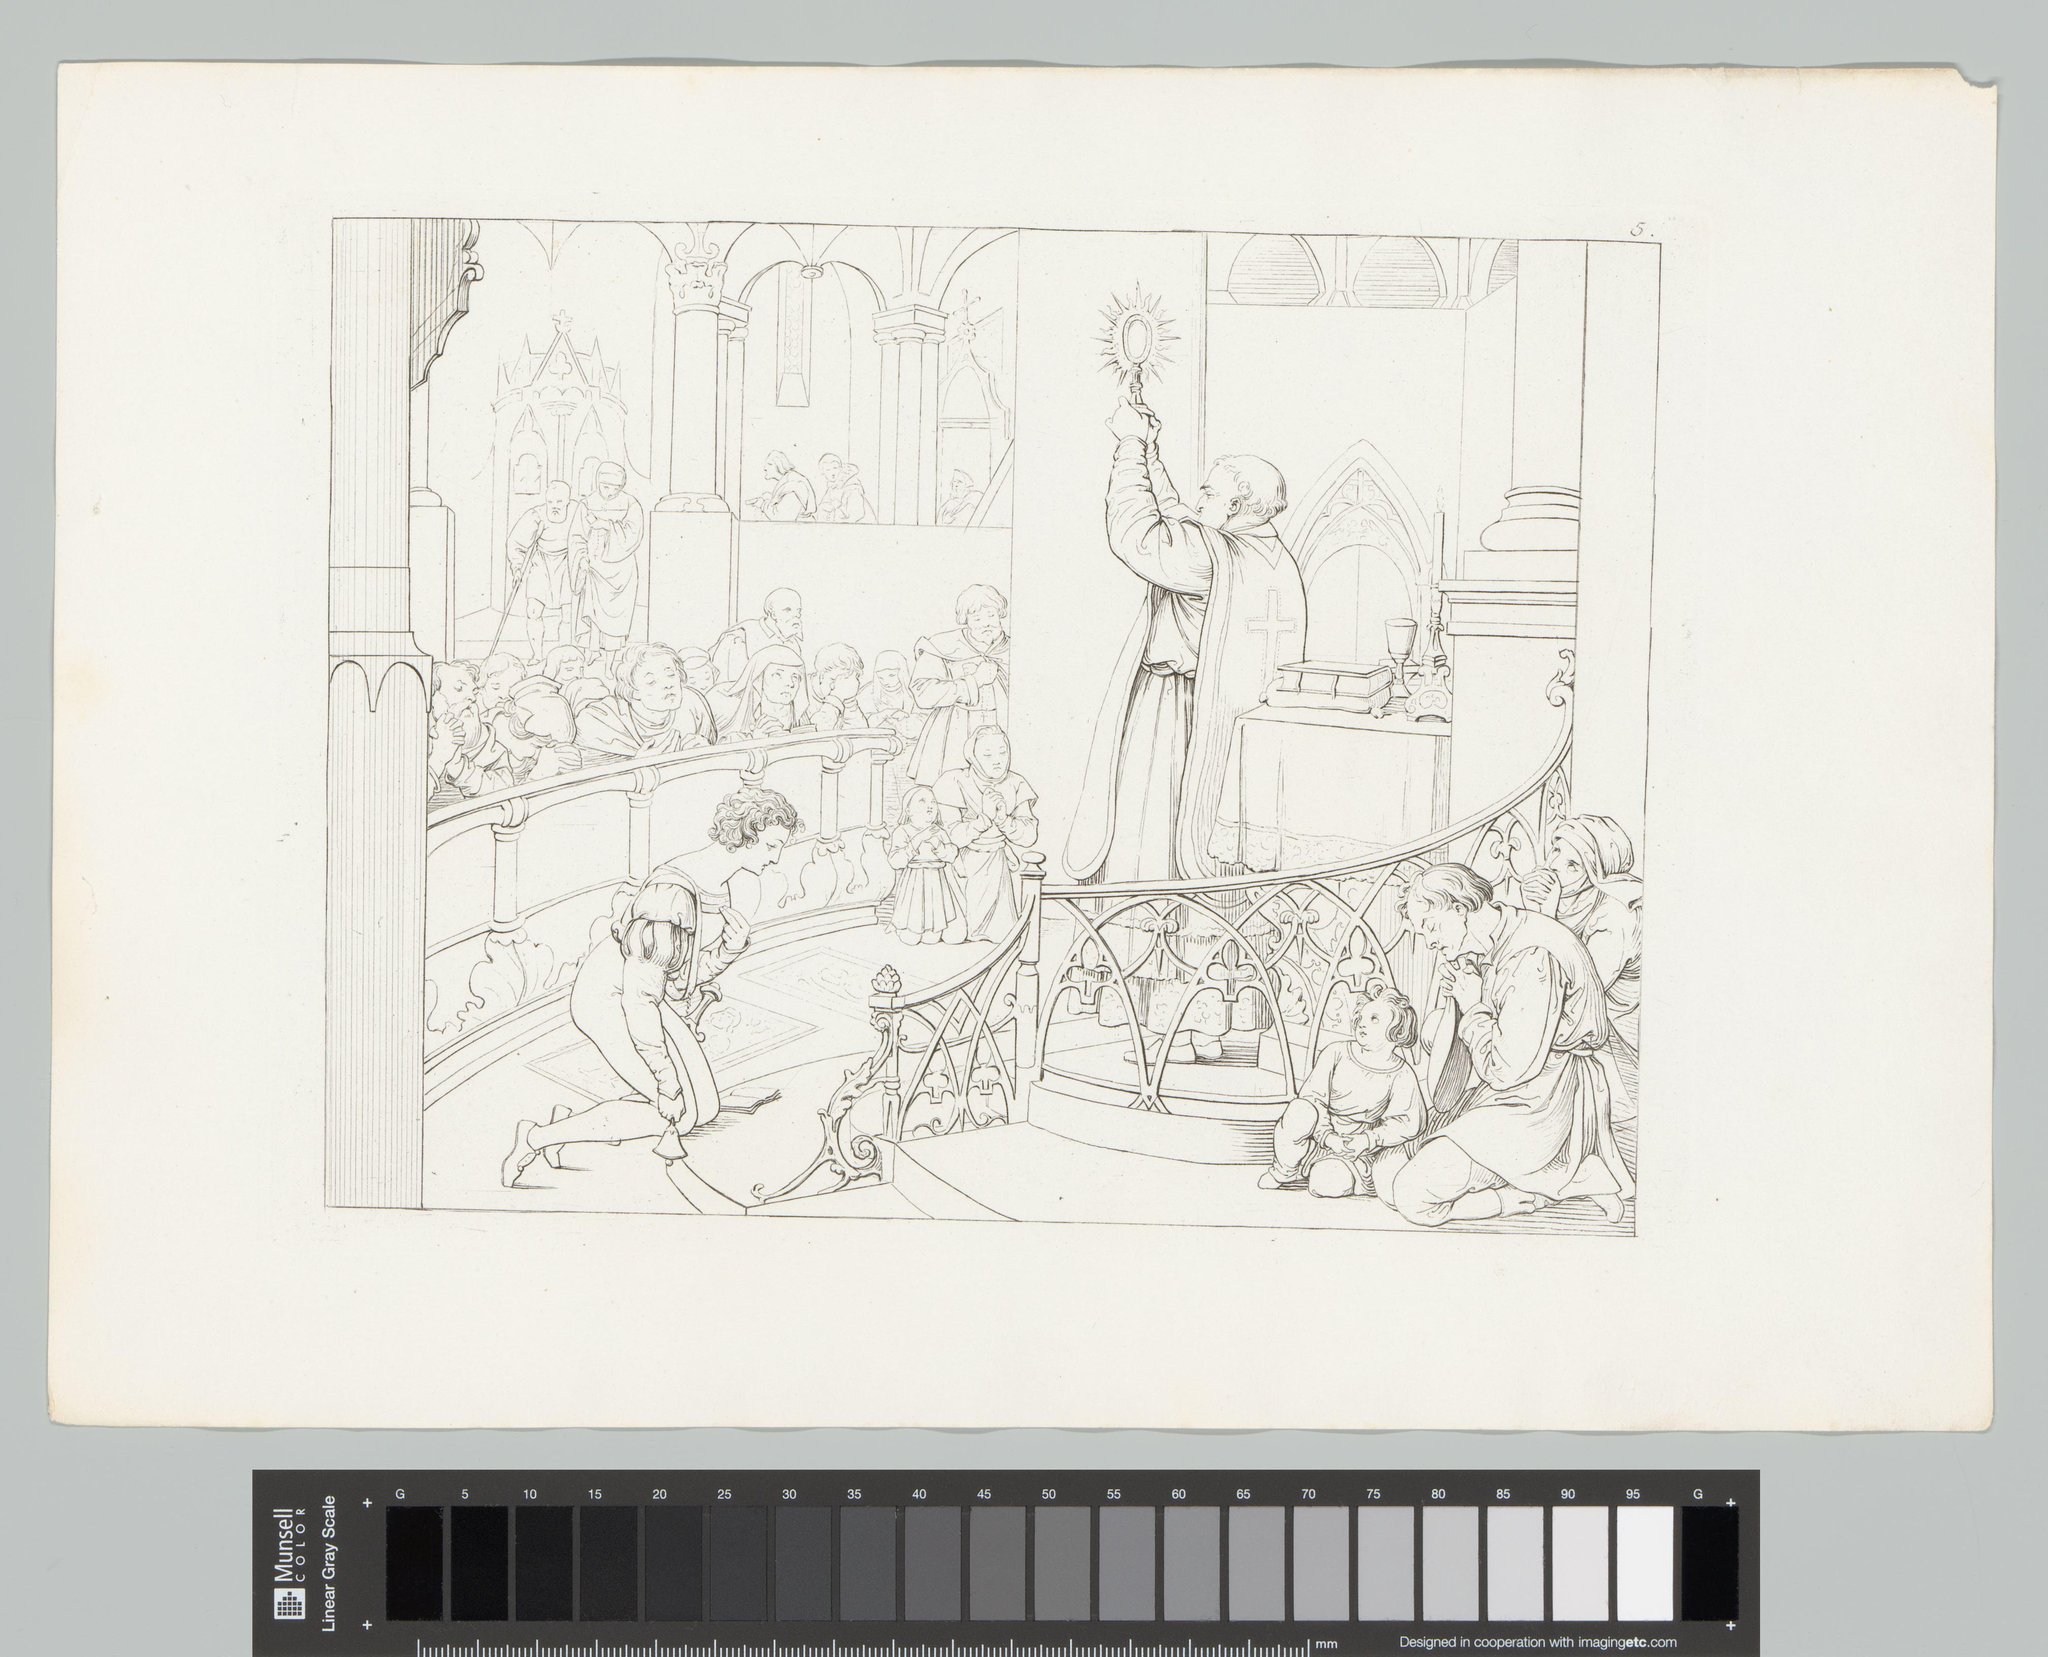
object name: print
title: Umrisse zu Schiller's Fridolin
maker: moritz retzsch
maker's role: print maker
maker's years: 1779-1857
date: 1823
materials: paper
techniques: etching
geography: tübingen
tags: the congregation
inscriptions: date